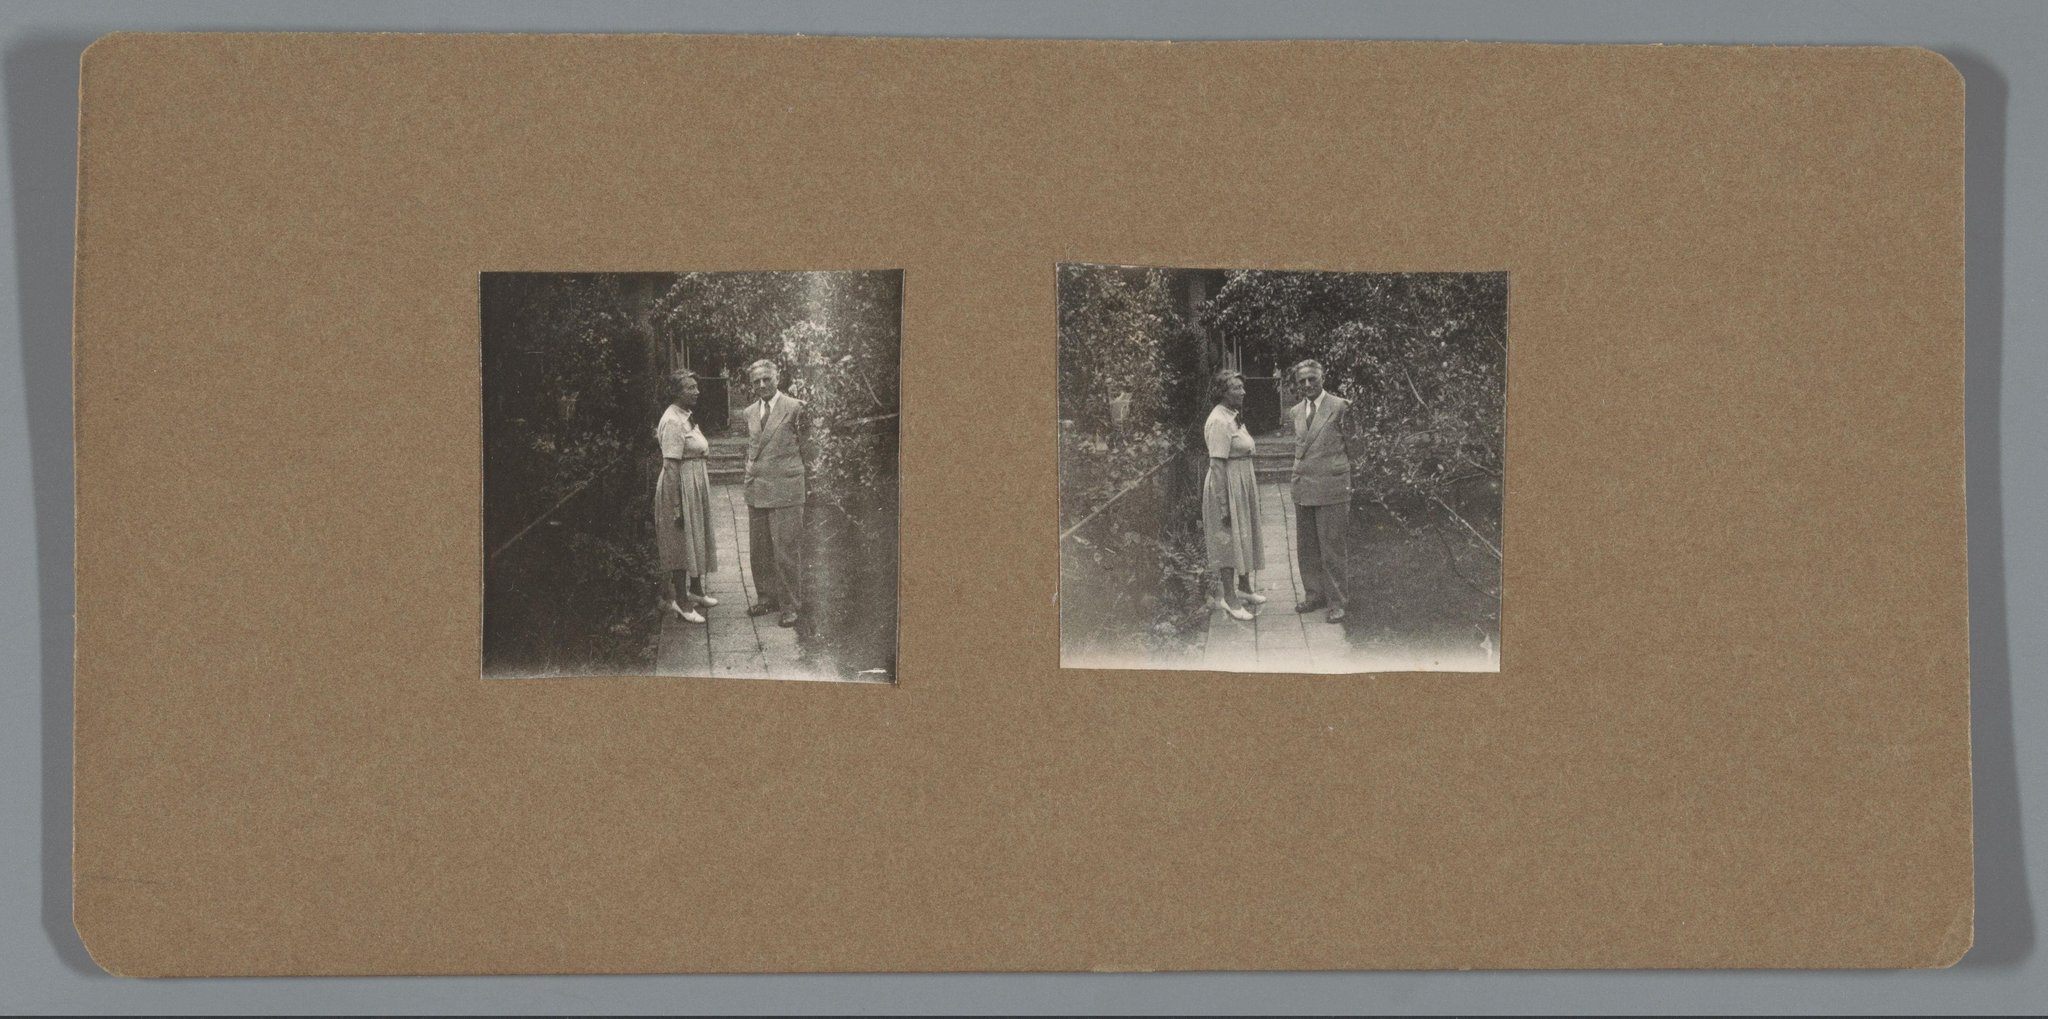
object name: stereograph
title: Man en vrouw in een tuin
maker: Anonymous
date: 1940-1950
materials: paper, cardboard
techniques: gelatin silver print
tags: adult woman, adult man